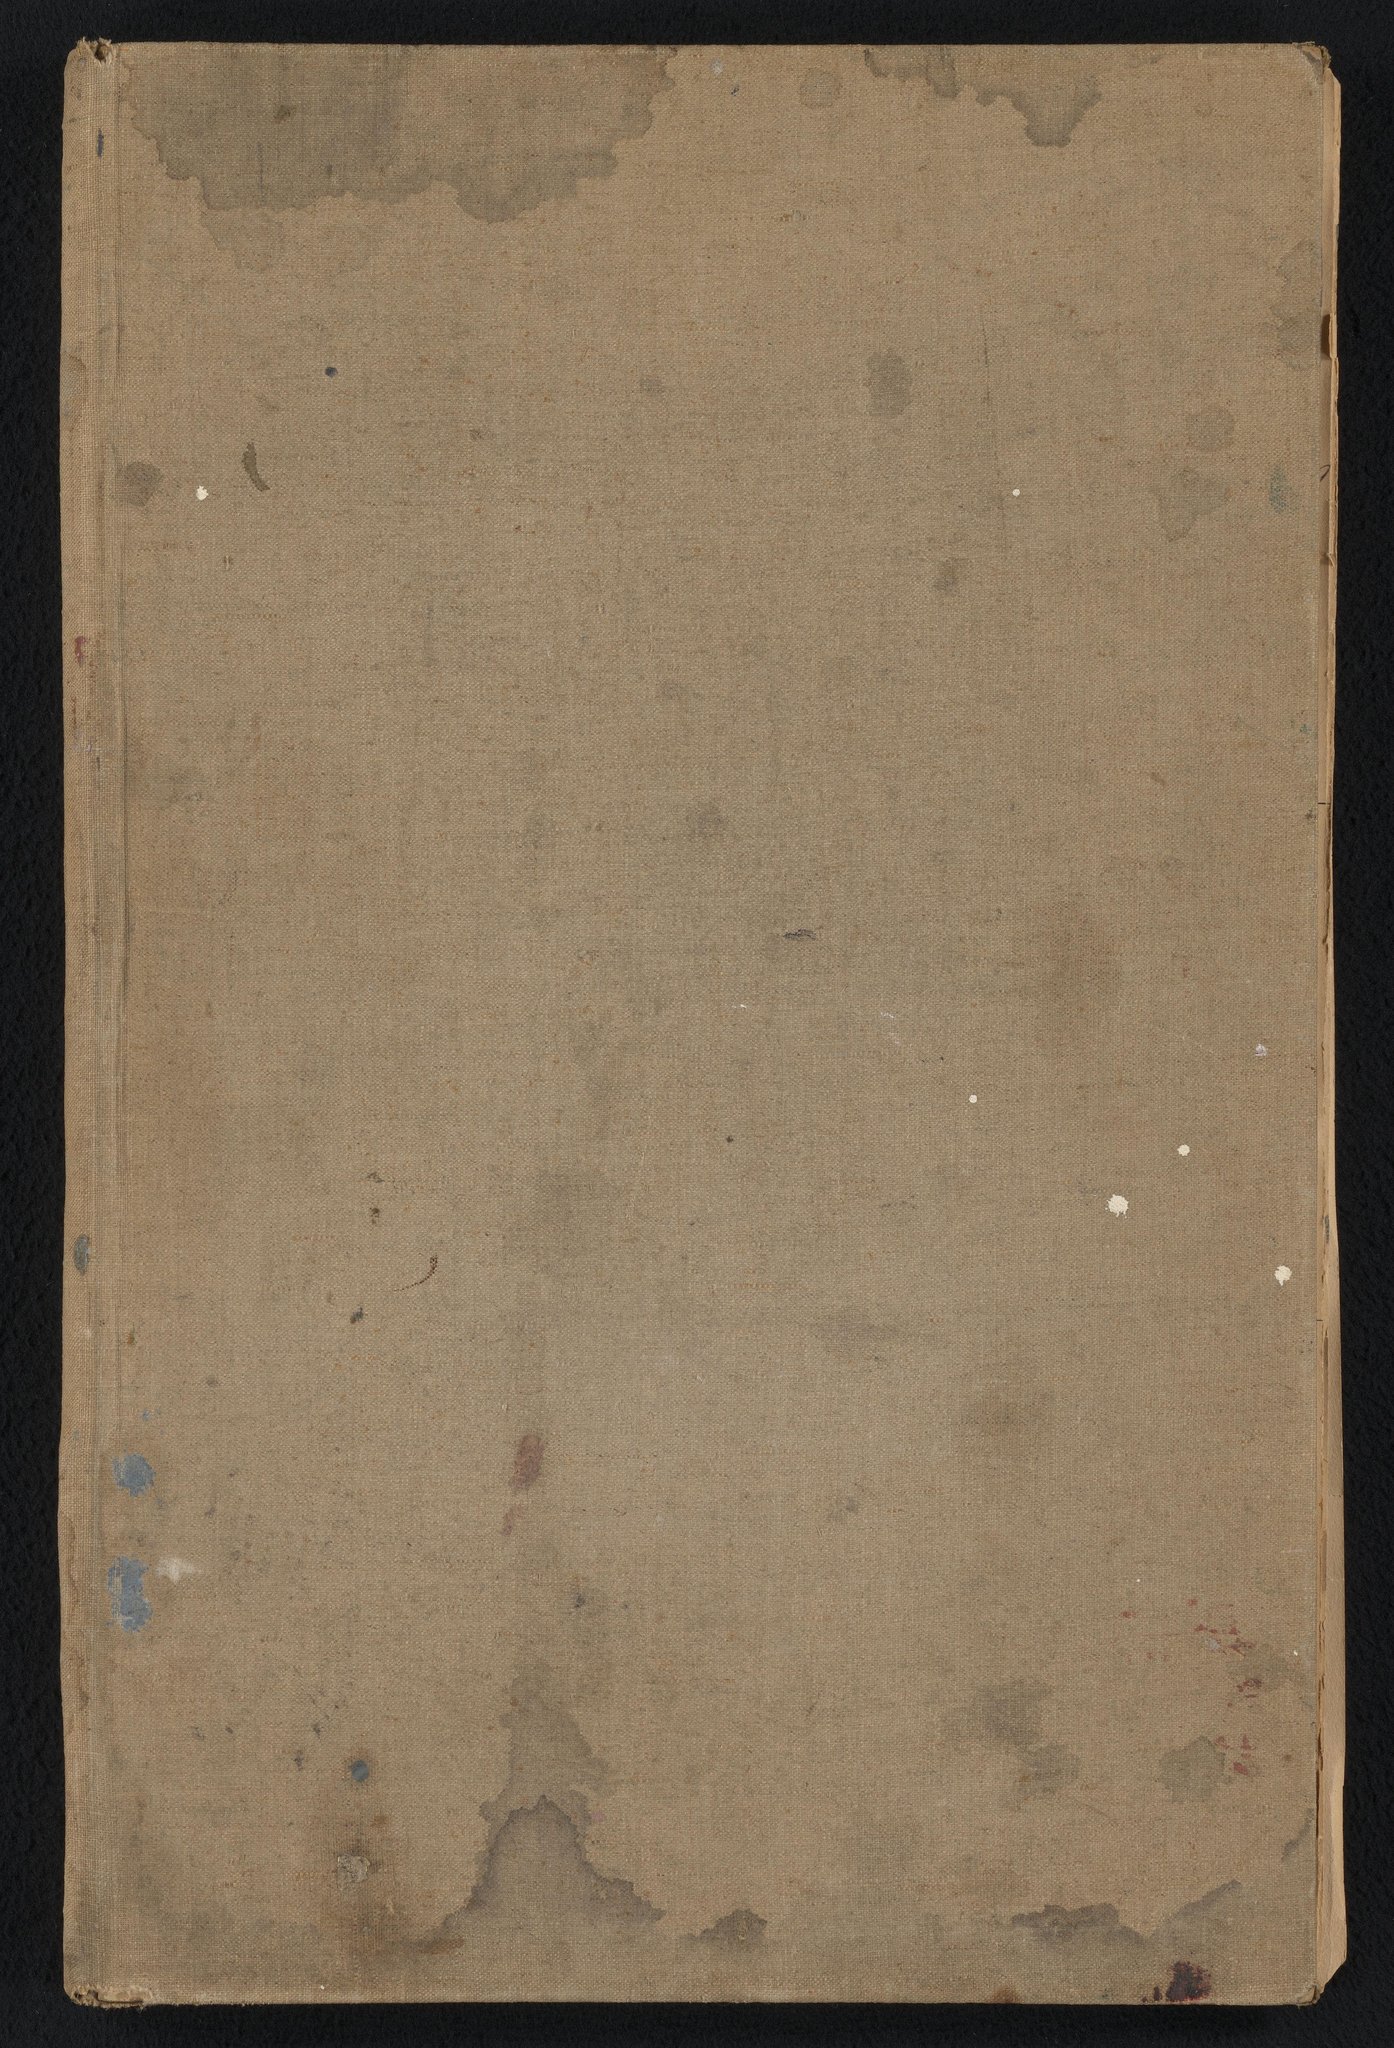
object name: sketchbook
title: Schetsboek met 24 bladen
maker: huib luns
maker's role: draughtsman, print maker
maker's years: 1881-1942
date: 1908-1909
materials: cardboard, chalk, charcoal, ink, linen, paper, pencil, watercolor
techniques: brush, pen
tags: christ as adult, anonymous historical person portrayed, mathematical perspective, poster, utrecht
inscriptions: retailer's mark: ‘[...] de in/ COÓPERATIVE ARTISTIQUE/ 58 Rue de Namur, 56’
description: Schetsboek bestaande uit 24 bladen en drie losse tekeningen met portretten, perspectiefstudies, handen, Bijbelvoorstellingen en ontwerpen voor reclamedrukwerk.